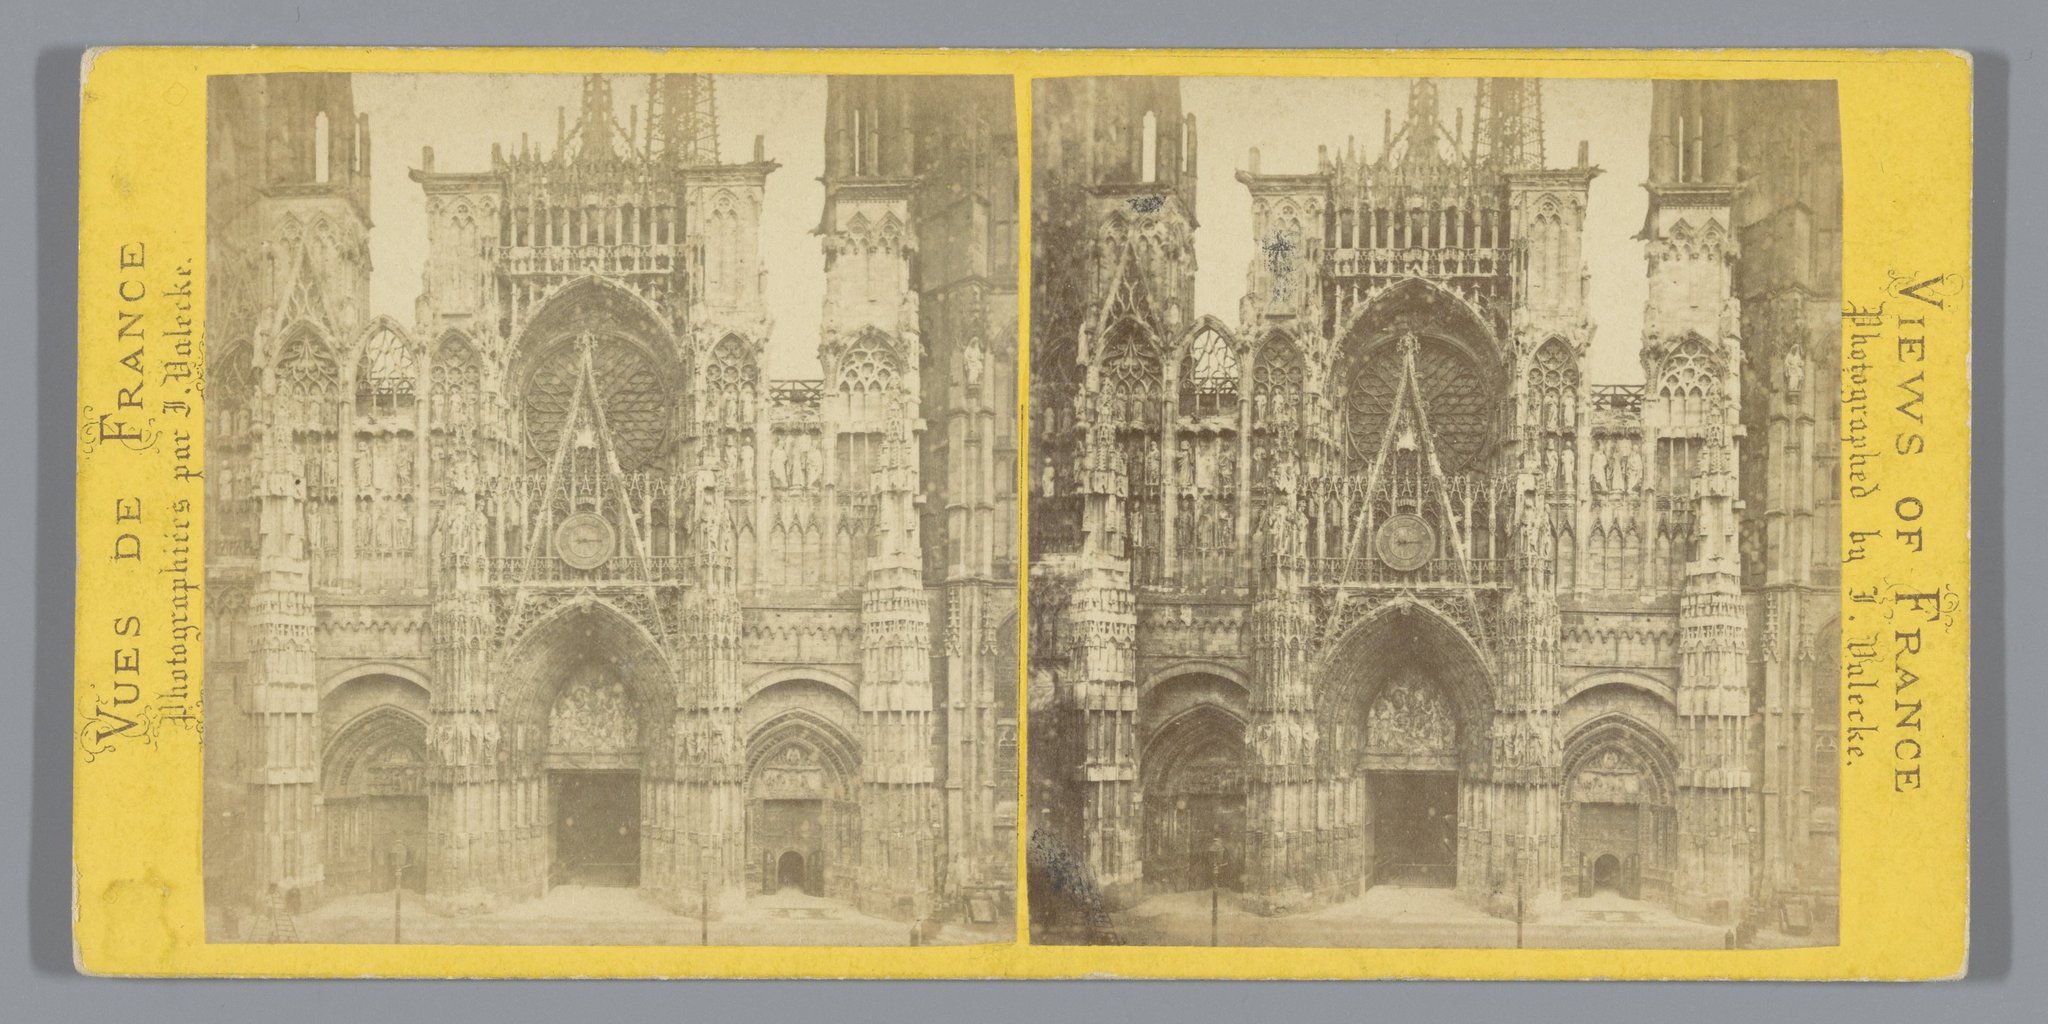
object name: stereograph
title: Rouen, Portail de la Cathedrale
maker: jules valecke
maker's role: fotograaf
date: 1860-1880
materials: cardboard, photographic support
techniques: albumen print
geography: rouen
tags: kathedraal van rouen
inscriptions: number: ‘No. 449.’